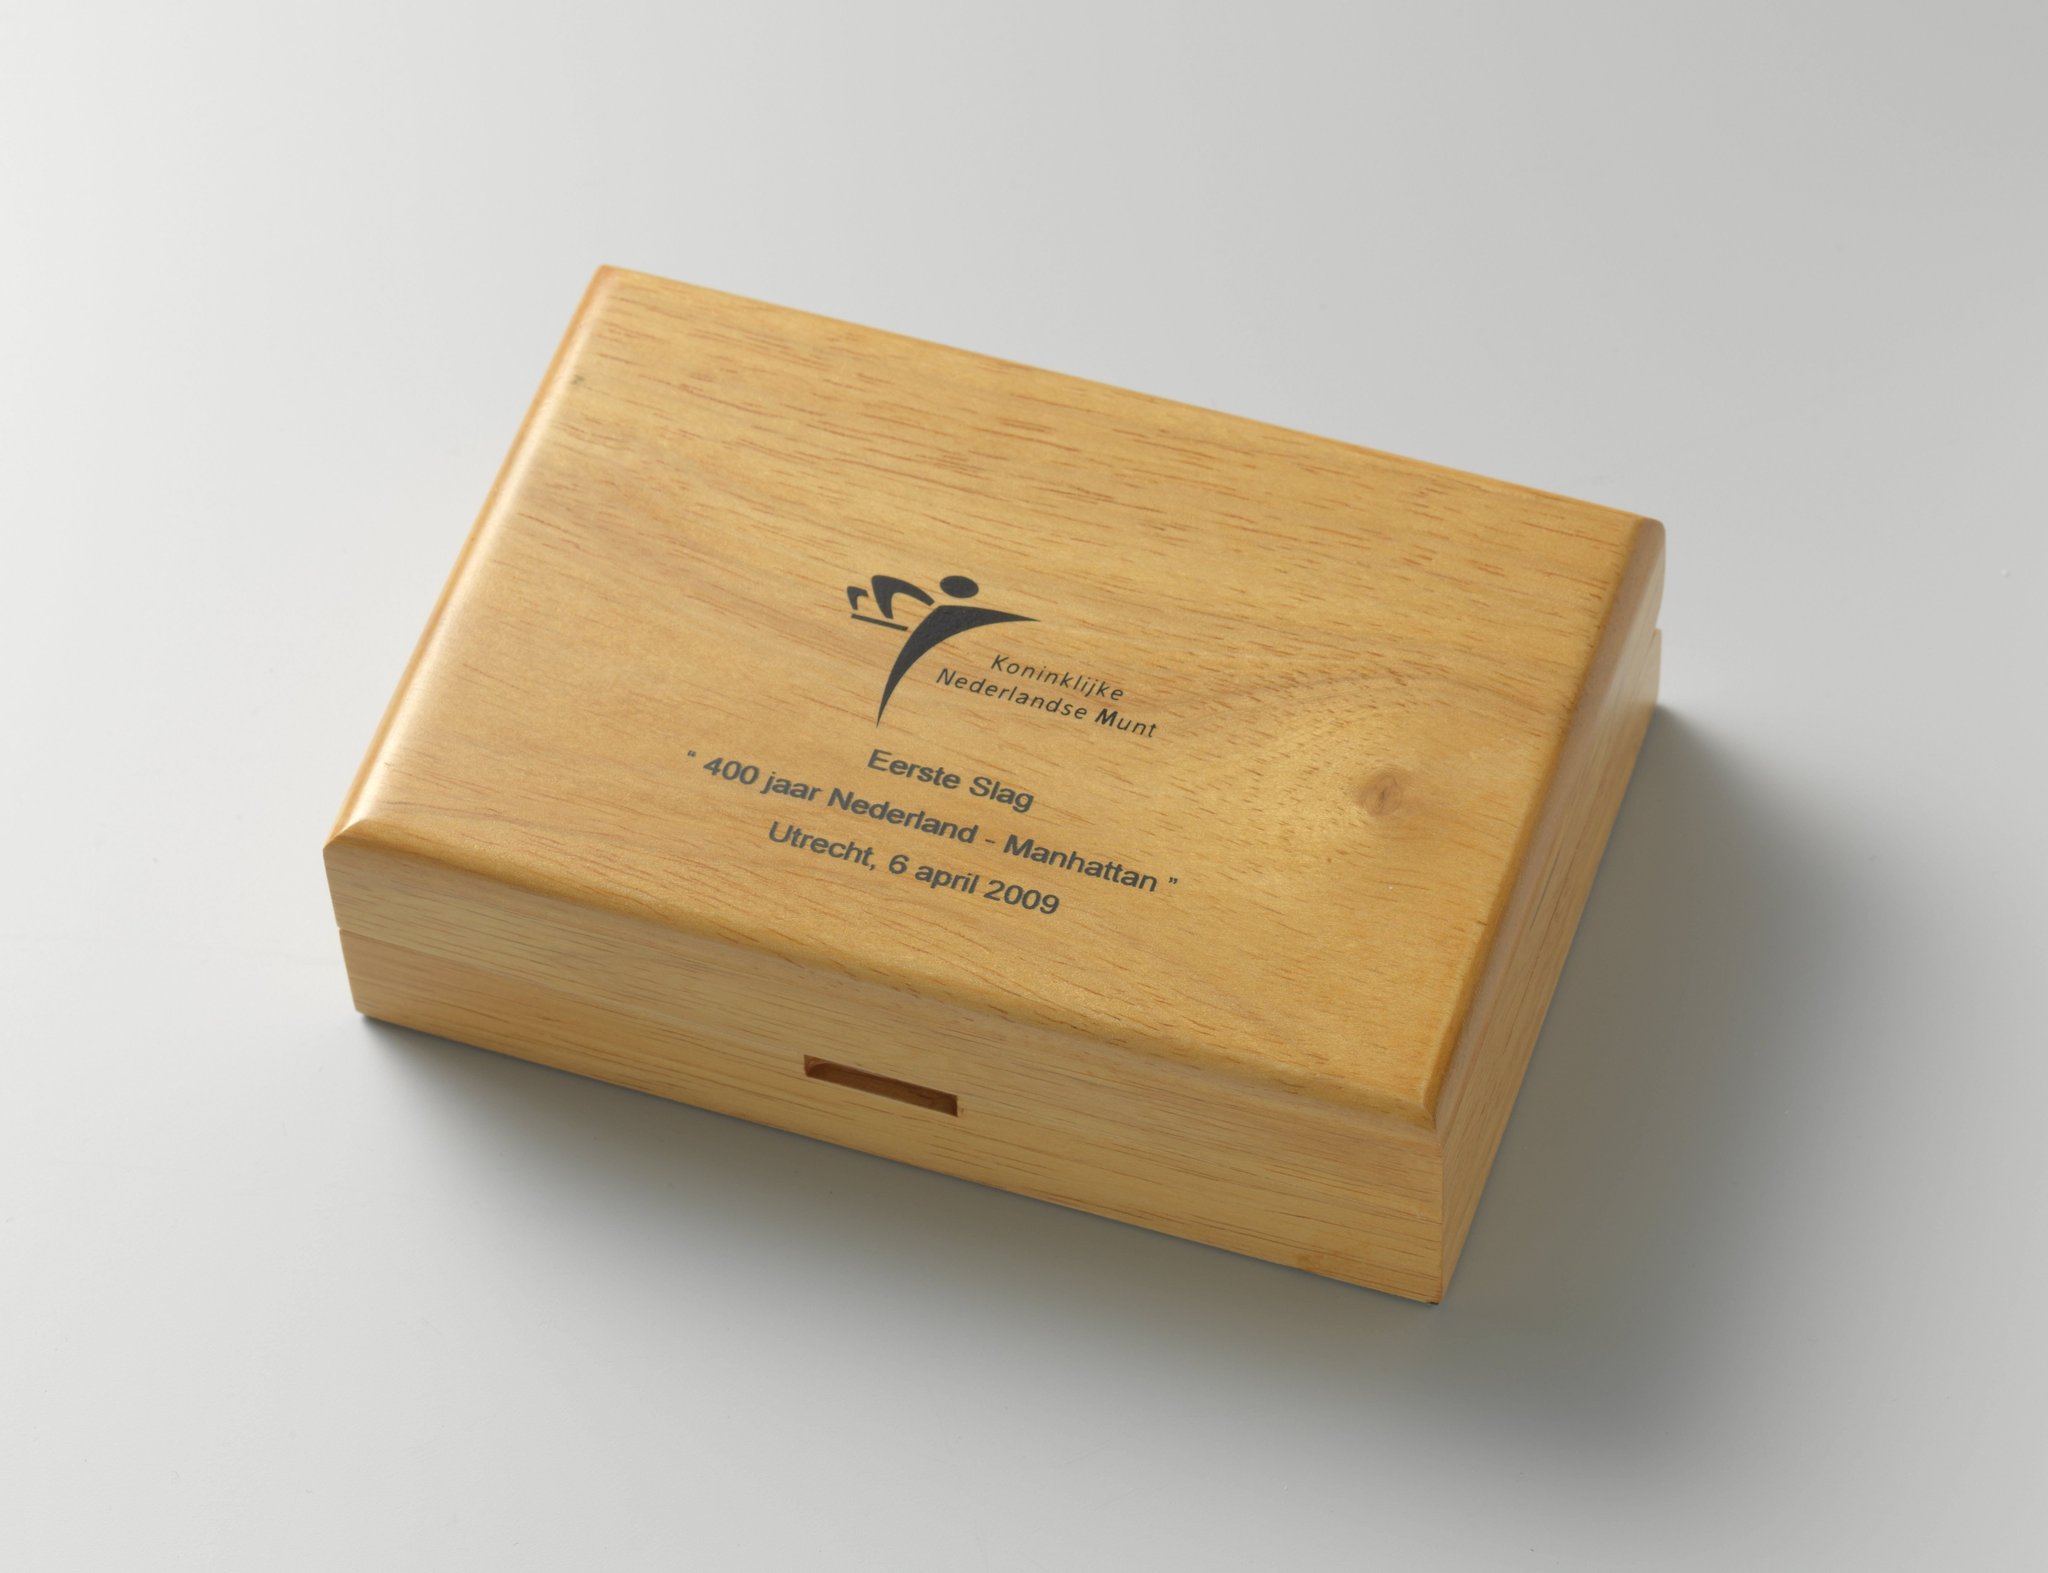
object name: box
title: Houten doosje bij munt 400 jaar Nederland-Manhattan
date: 2009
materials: paper, velvet, wood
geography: utrecht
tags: netherlands, manhattan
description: Manhattan was de plek waar een Nederlandse expeditie onder leiding van Henry Hudson in 1609 landde, die uitgroeide tot het huidige New York.